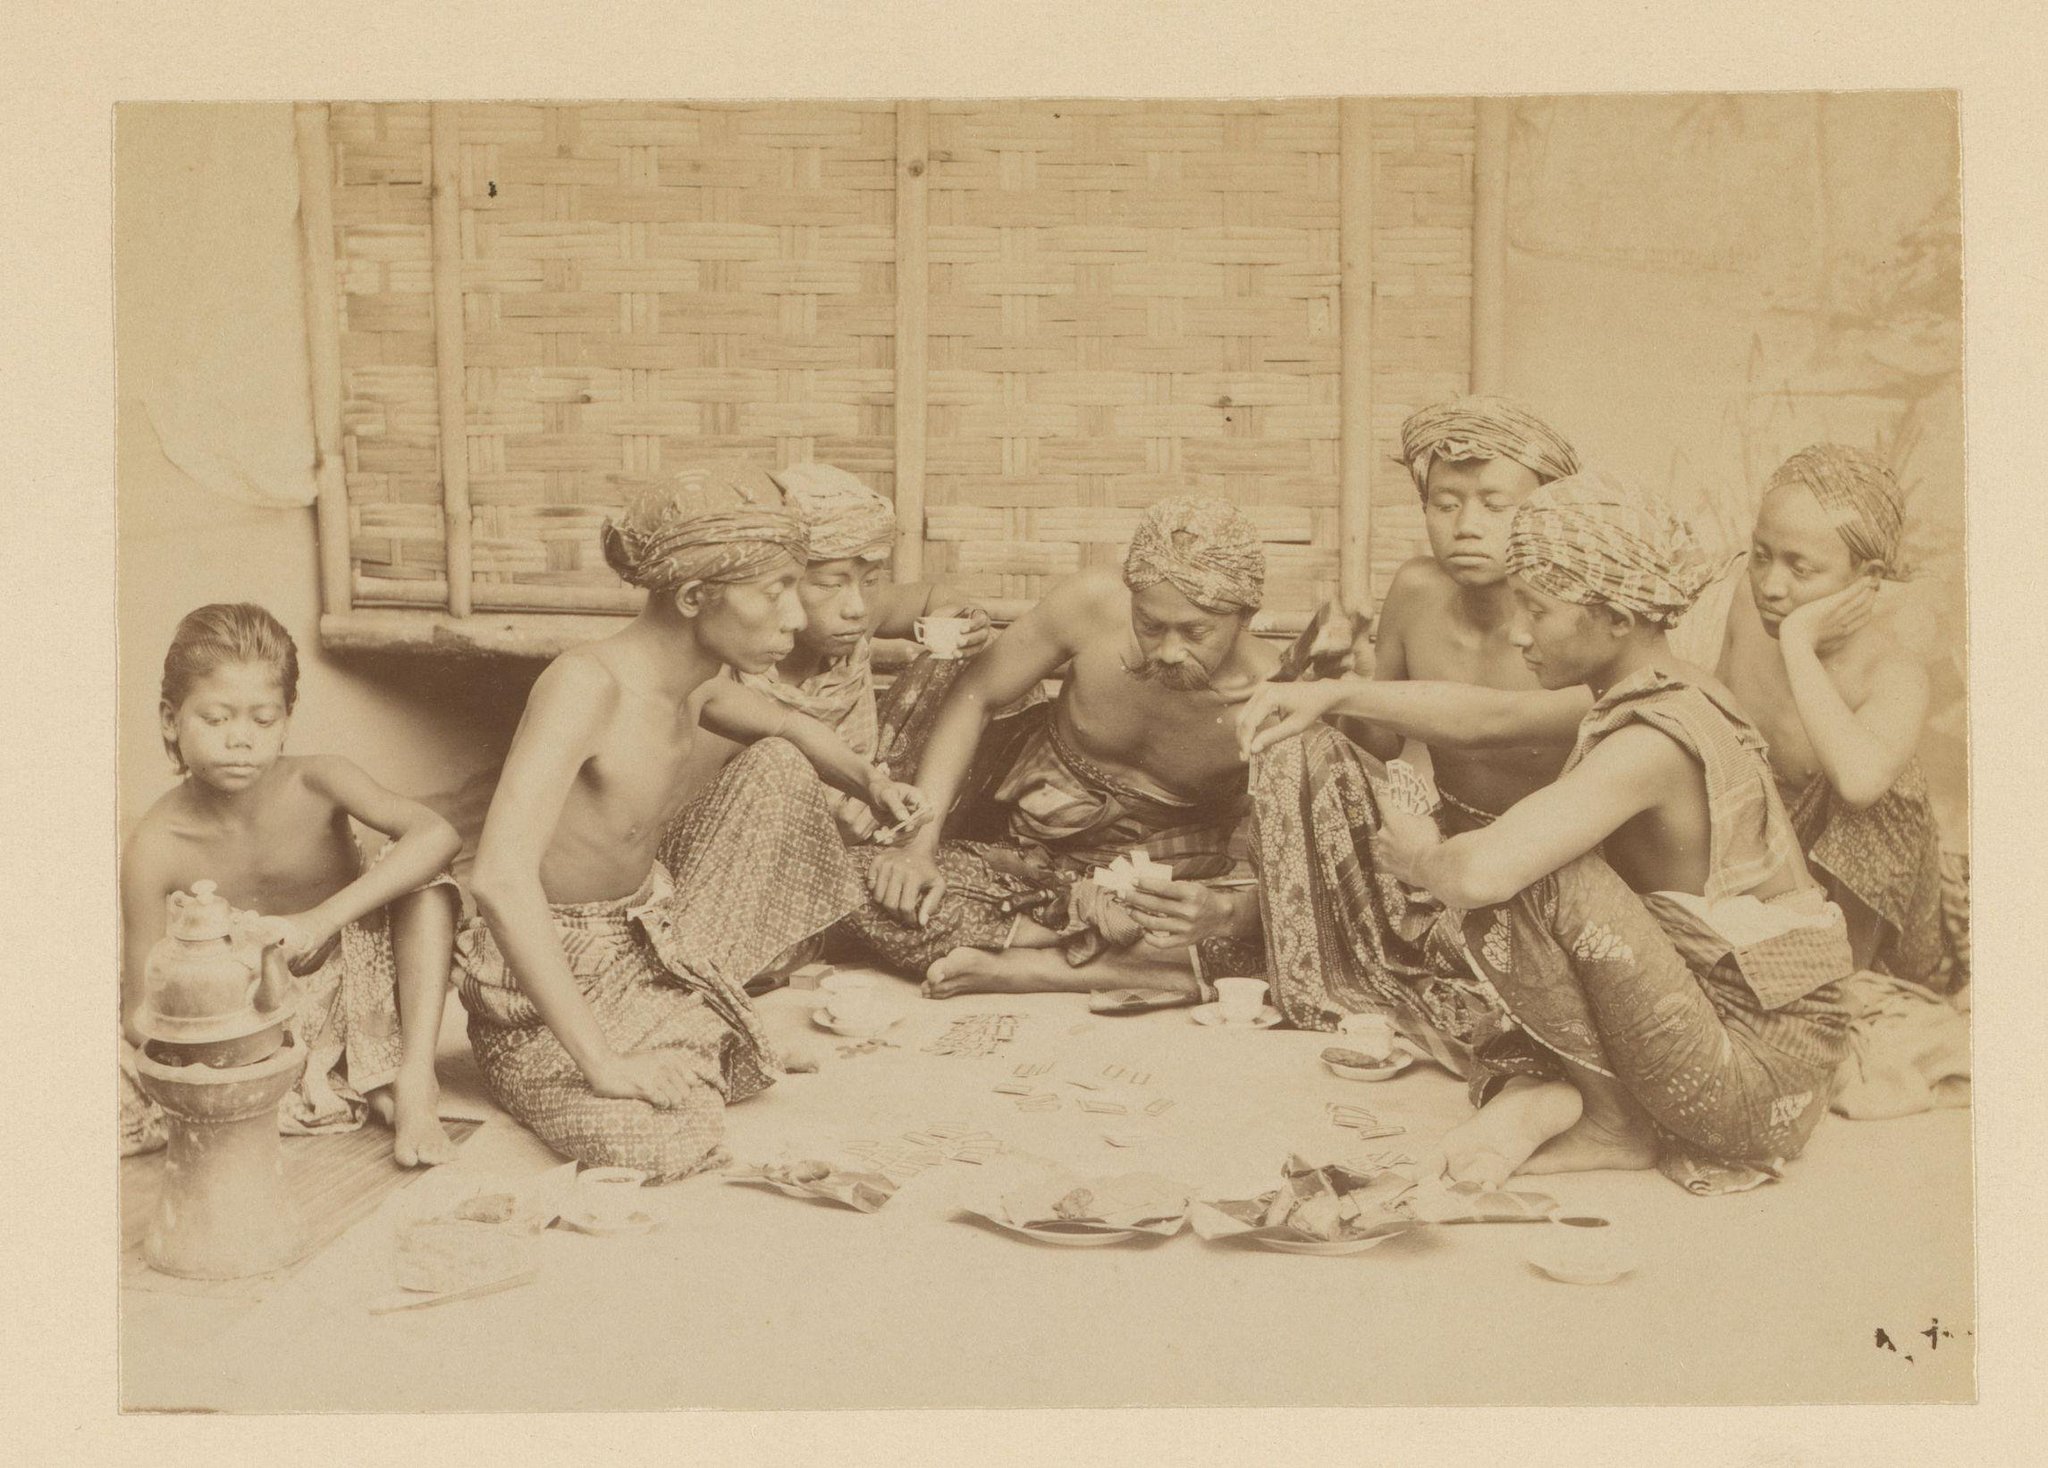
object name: photograph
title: Kaartspelende mannen, zittend op de grond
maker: Anonymous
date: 1851-1900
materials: cardboard, paper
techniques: albumen print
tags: playing-cards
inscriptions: inscription: ‘FOTO’